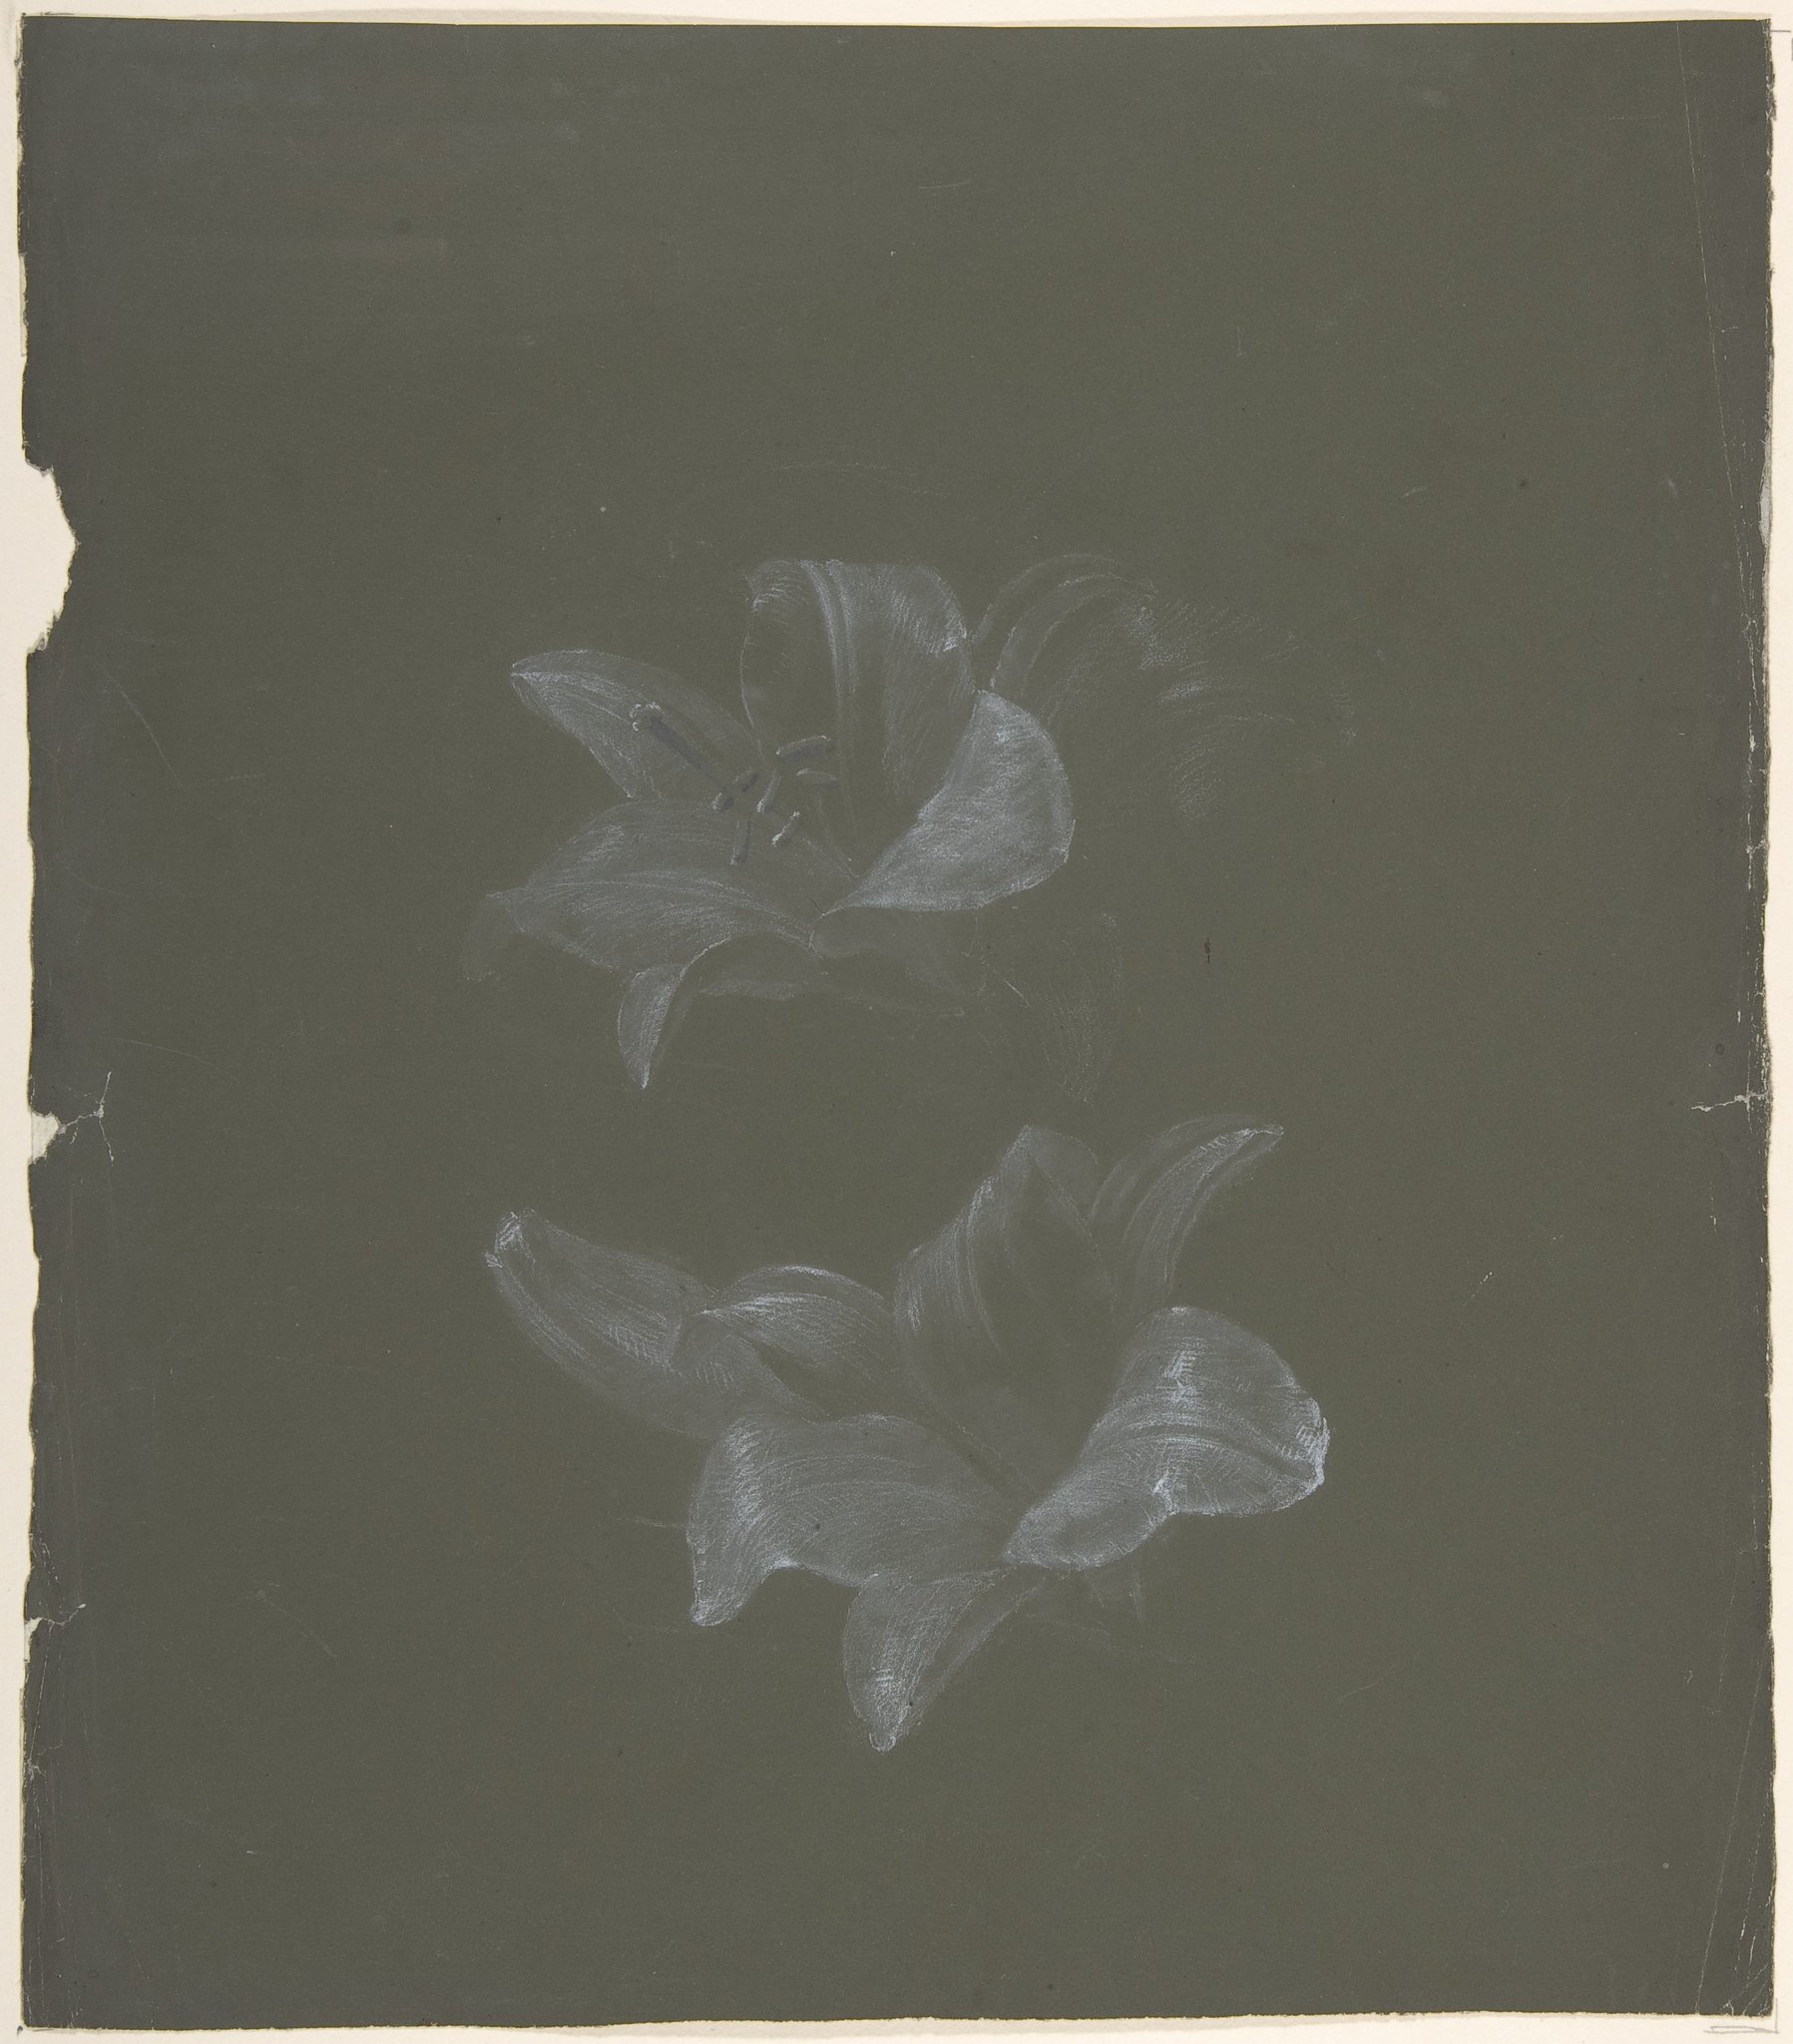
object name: drawing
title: Floral Design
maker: antoine berjon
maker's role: artist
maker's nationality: french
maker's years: 1754-1843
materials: chalk, graphite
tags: flowers